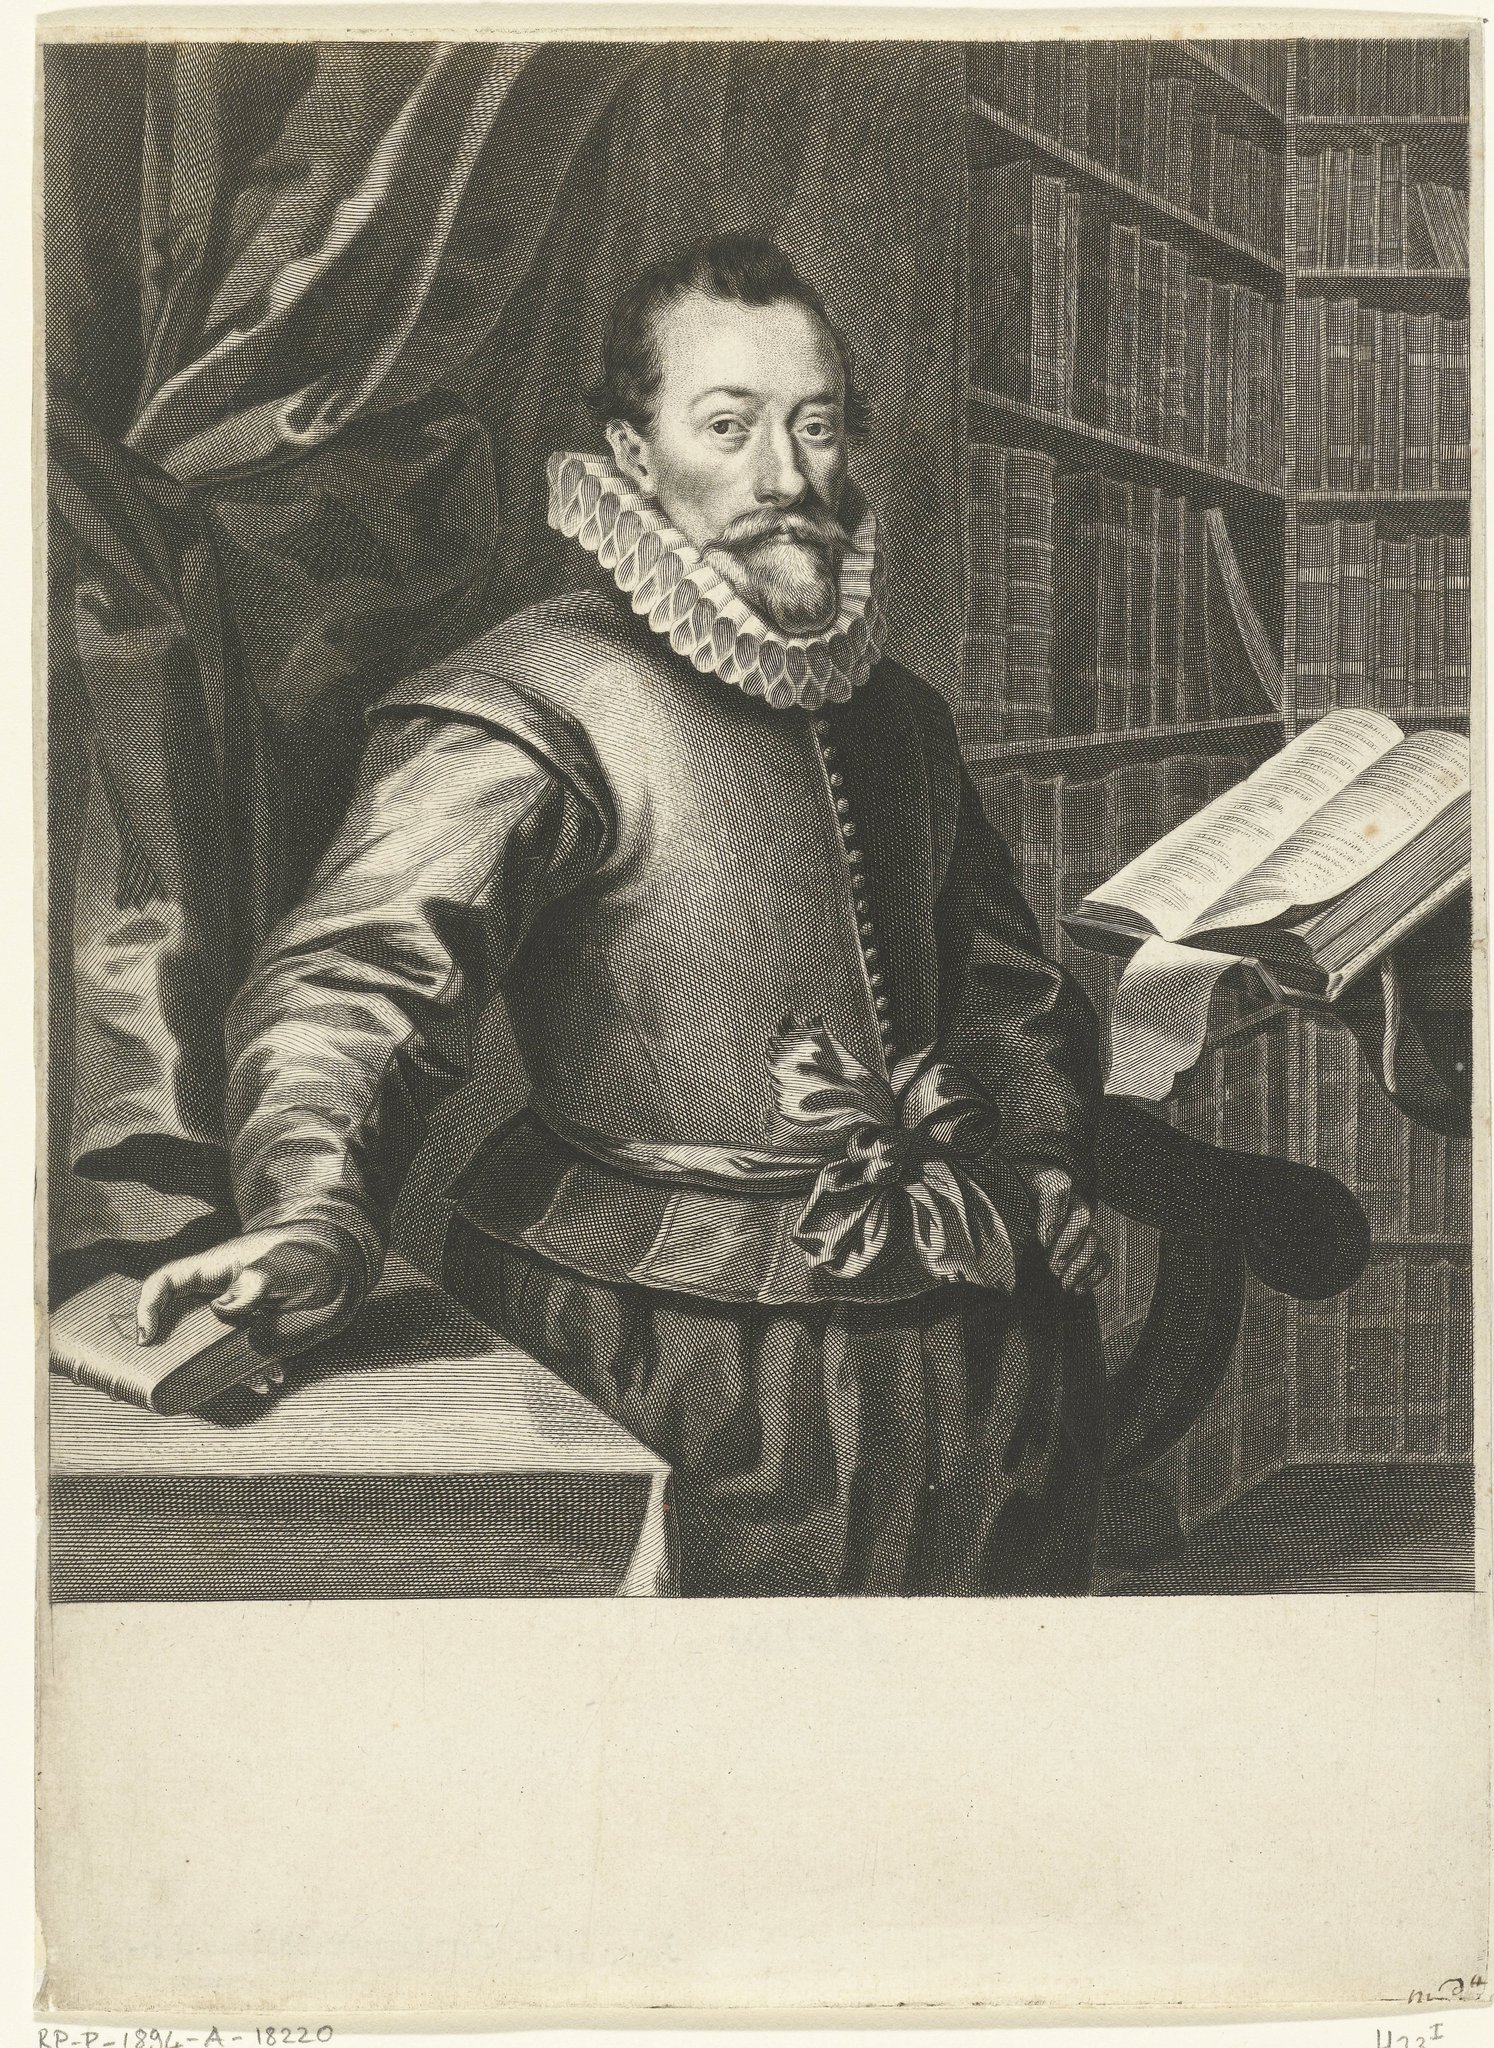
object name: print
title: Portret van Jacobus Taurinus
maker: hendrik bary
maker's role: draughtsman, print maker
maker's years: 1640-1707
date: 1657-1707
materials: paper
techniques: engraving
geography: netherlands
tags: antwerp, study; 'studiolo'; library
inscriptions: collector's mark: Lugt 2228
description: Portret van Jacobus Taurinus, staand aan een lessenaar in een bibliotheek.